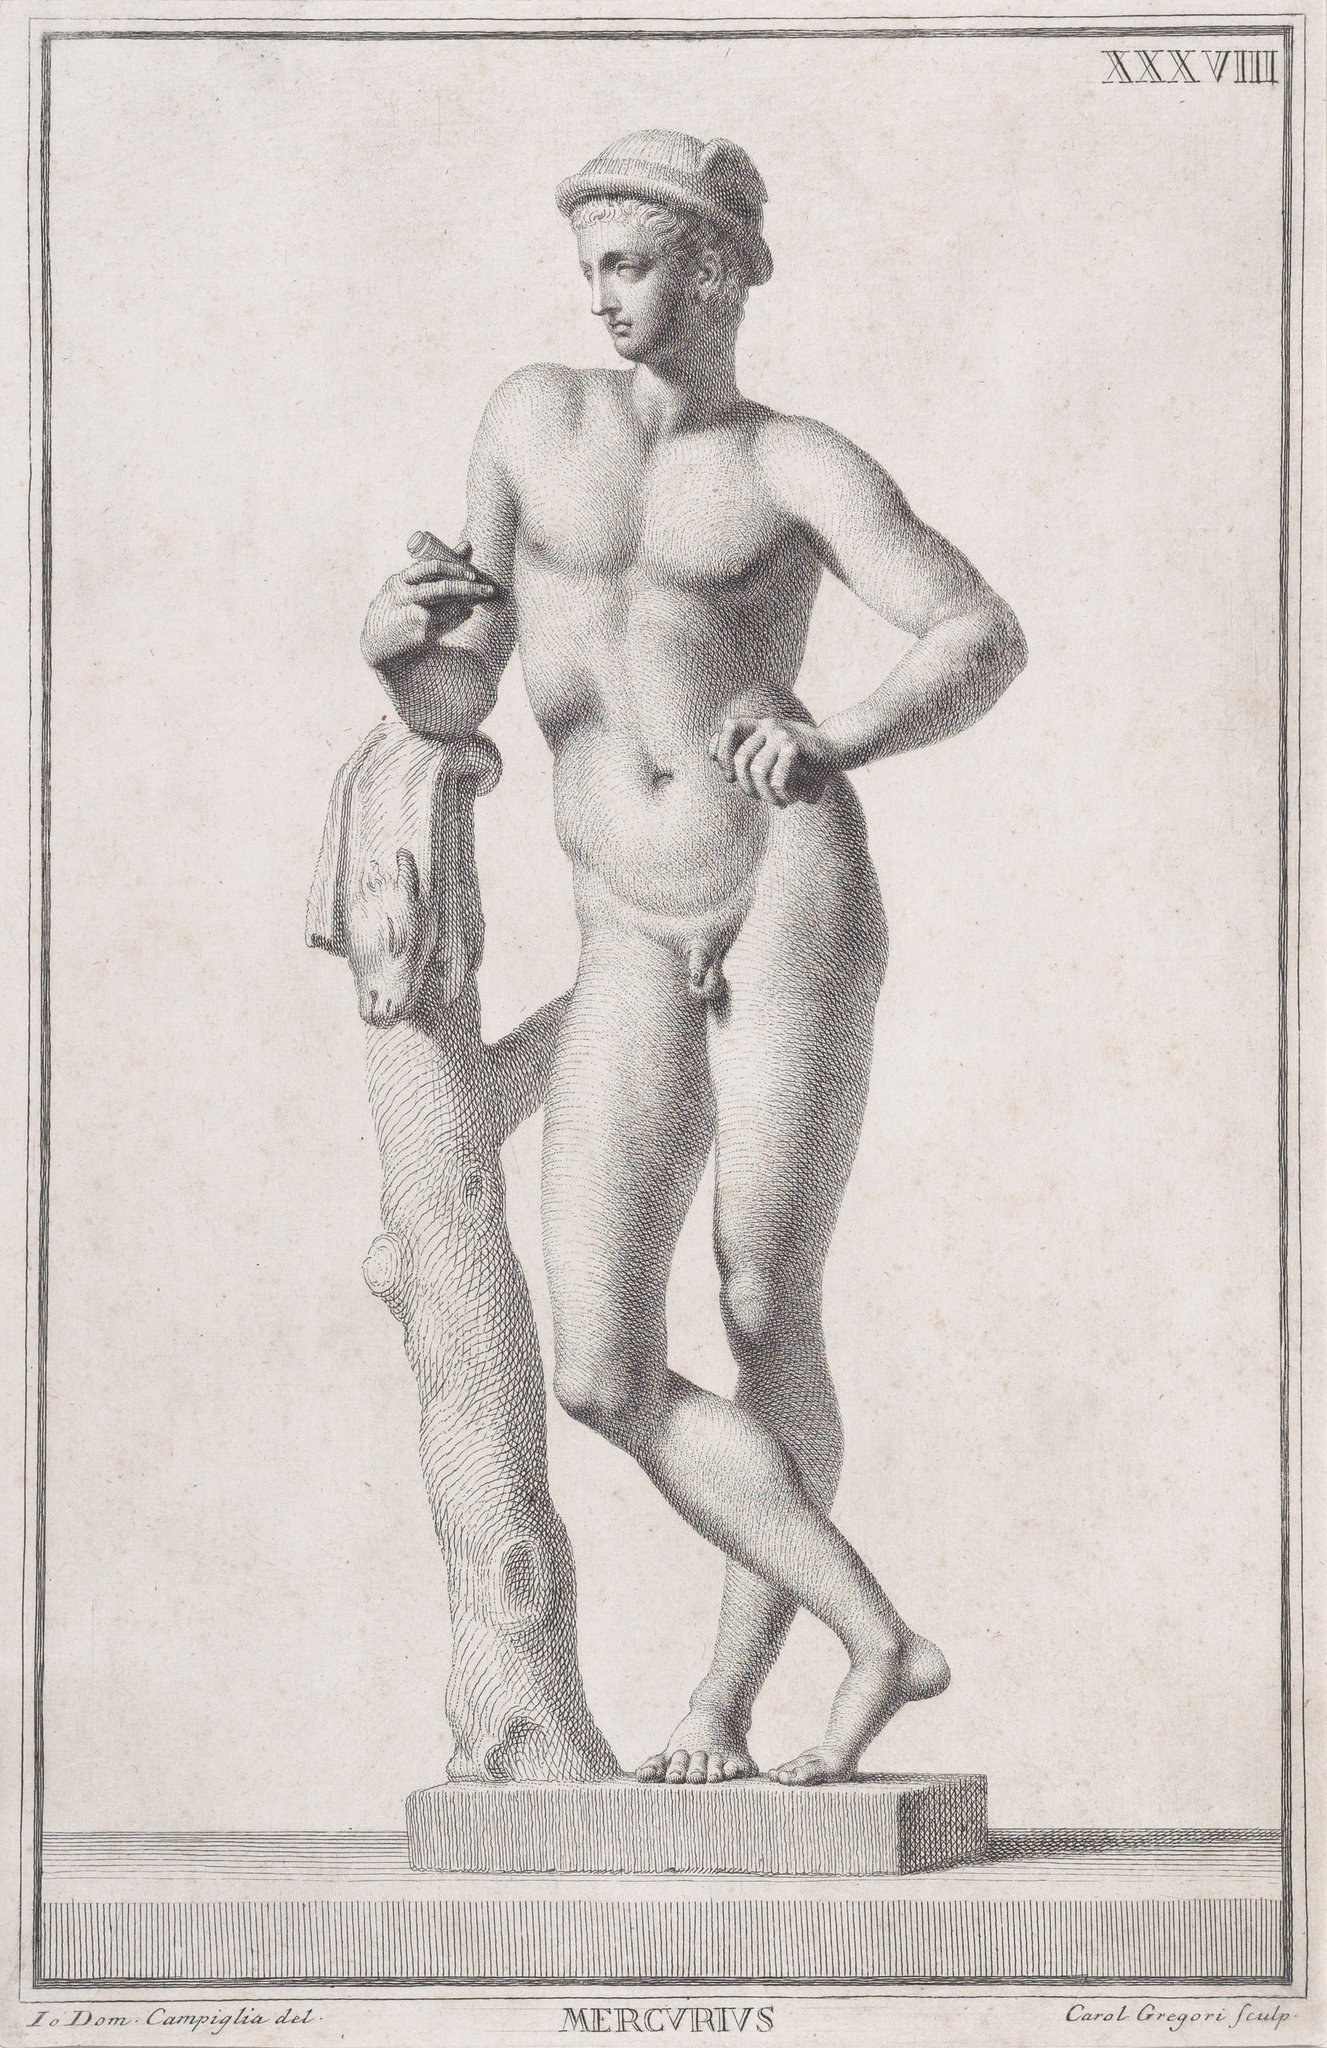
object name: print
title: Plate XXXVIII (38): Mercury, from "Museum Florentinum" (Statuae antiquae dorum et virorum illustrium)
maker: carlo gregori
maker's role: artist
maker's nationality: italian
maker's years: 1719-1759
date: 1734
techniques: engraving, etching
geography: florence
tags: male nudes,mercury